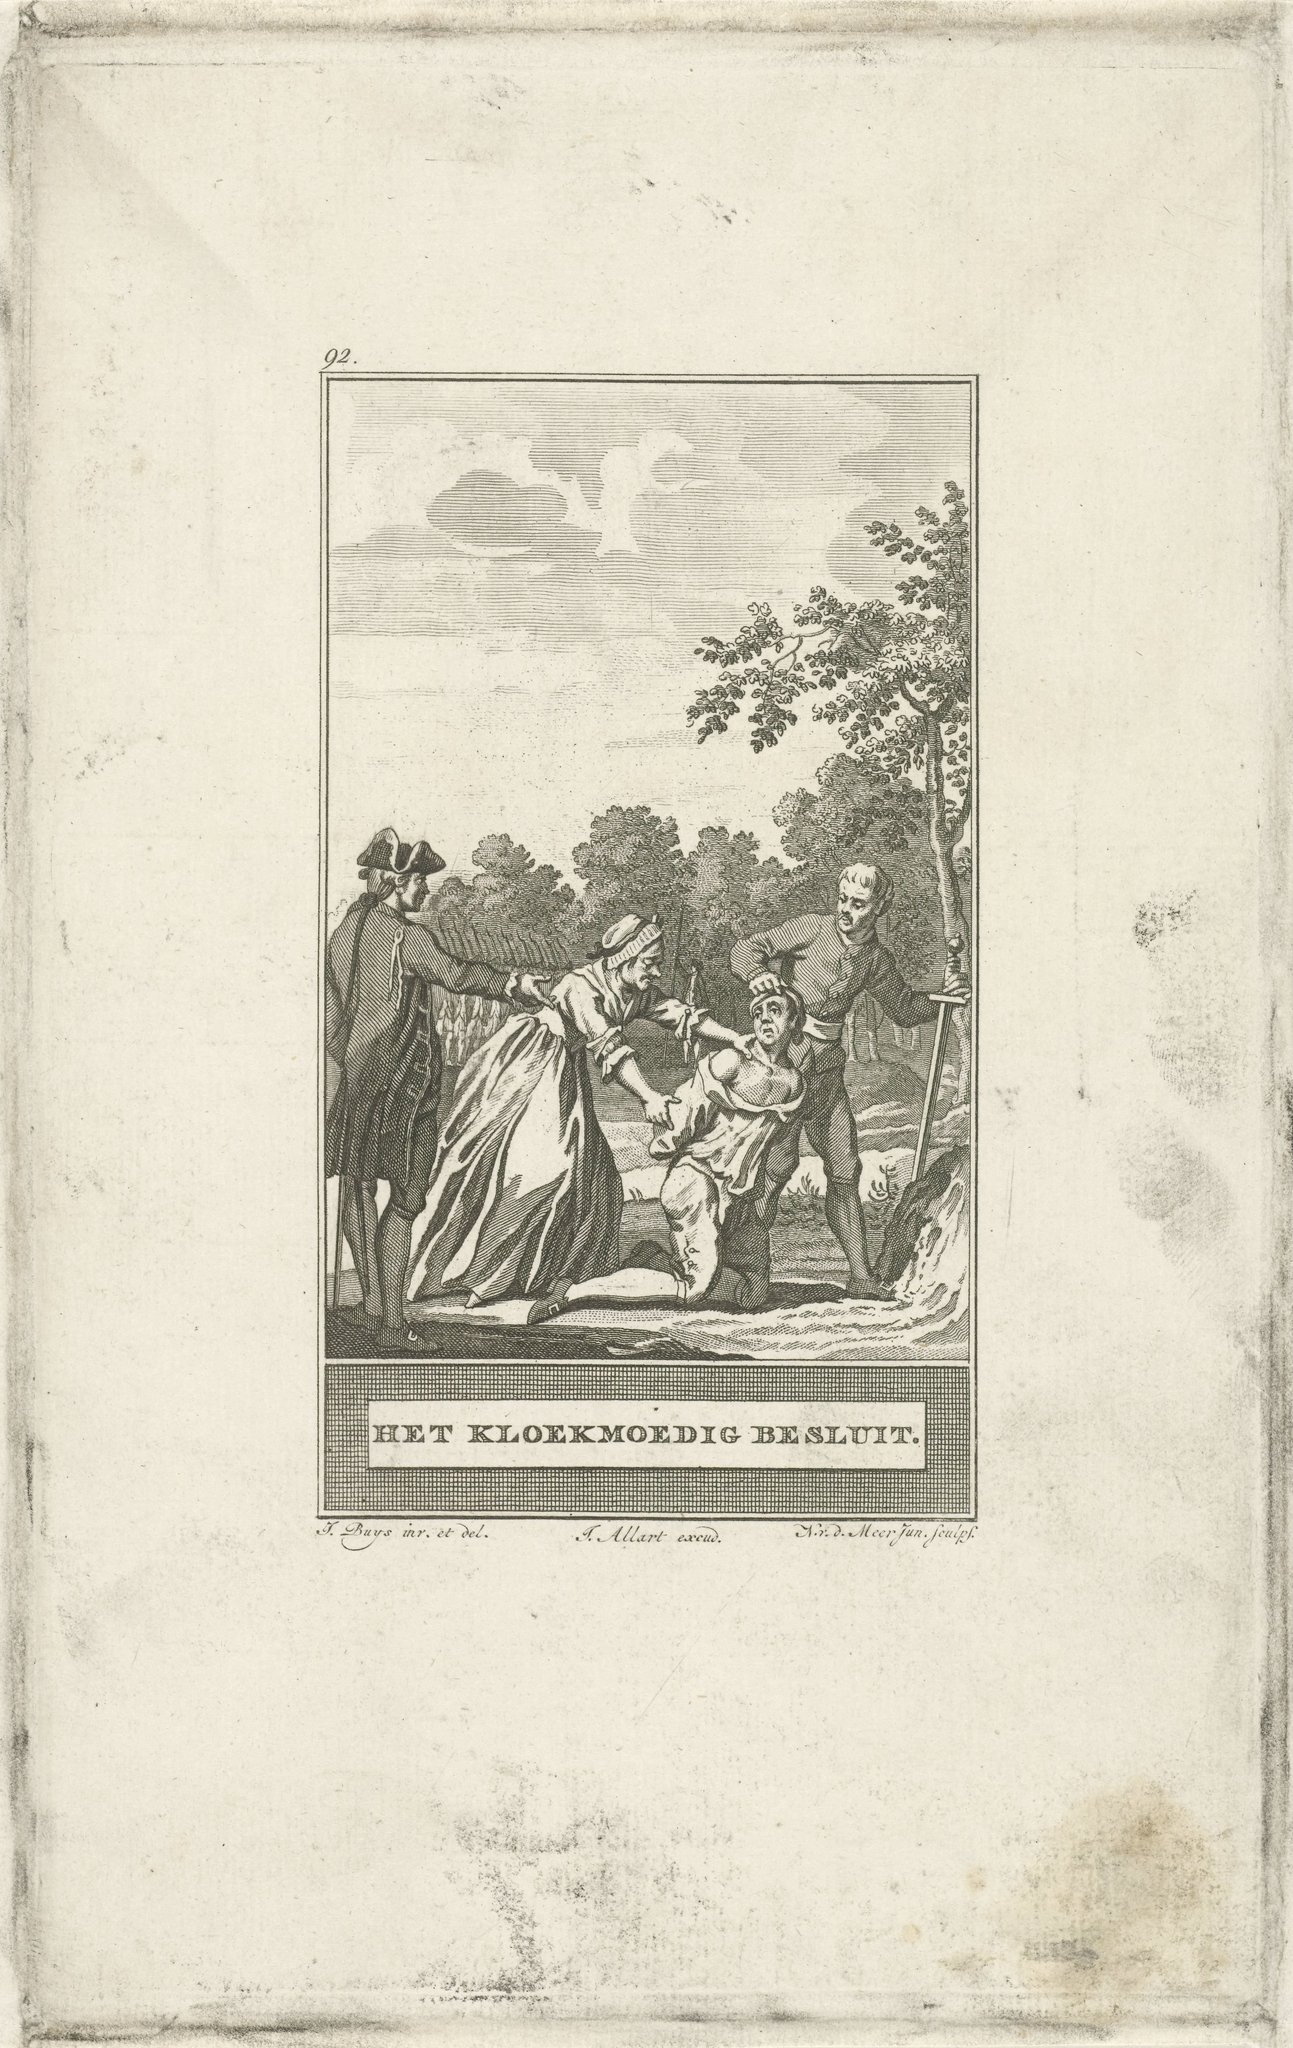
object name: book illustration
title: Het kloekmoedig besluit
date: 1778-1785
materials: paper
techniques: etching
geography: amsterdam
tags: last hours before execution, hacking and thrusting weapons: sword, ugly old woman, hag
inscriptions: collector's mark: Lugt 2228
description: Prent bij: Gellert, Christian Fürchtegott. Fabelen en vertelsels. 3 dln. Amsterdam: Pieter Meyer, 1772-1774. De prenten bij deze publicatie werden later uitgegeven. De exemplaren uitgegeven door de weduwe Jacobus Loveringh & Johannes Allart tussen 1777 en 1778, de exemplaren uitgegeven door alleen Johannes Allart tussen 1778 en 1785.